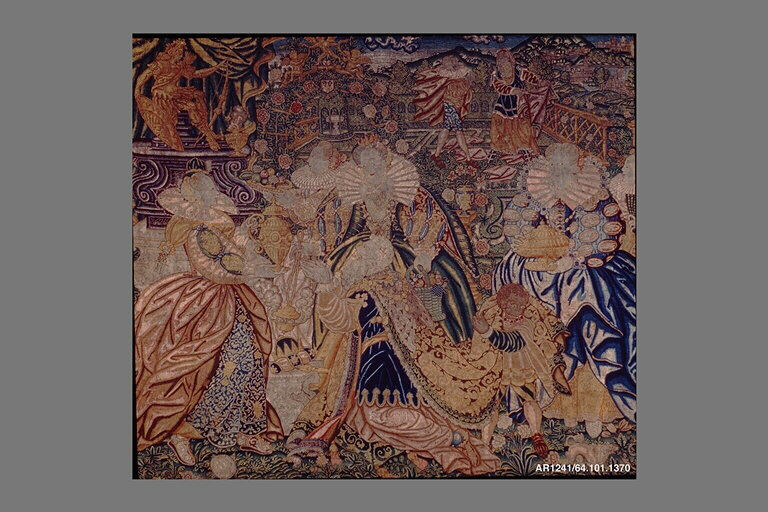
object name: panel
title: Panel with the story of King Solomon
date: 1600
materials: canvas, silk, wool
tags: kings,women